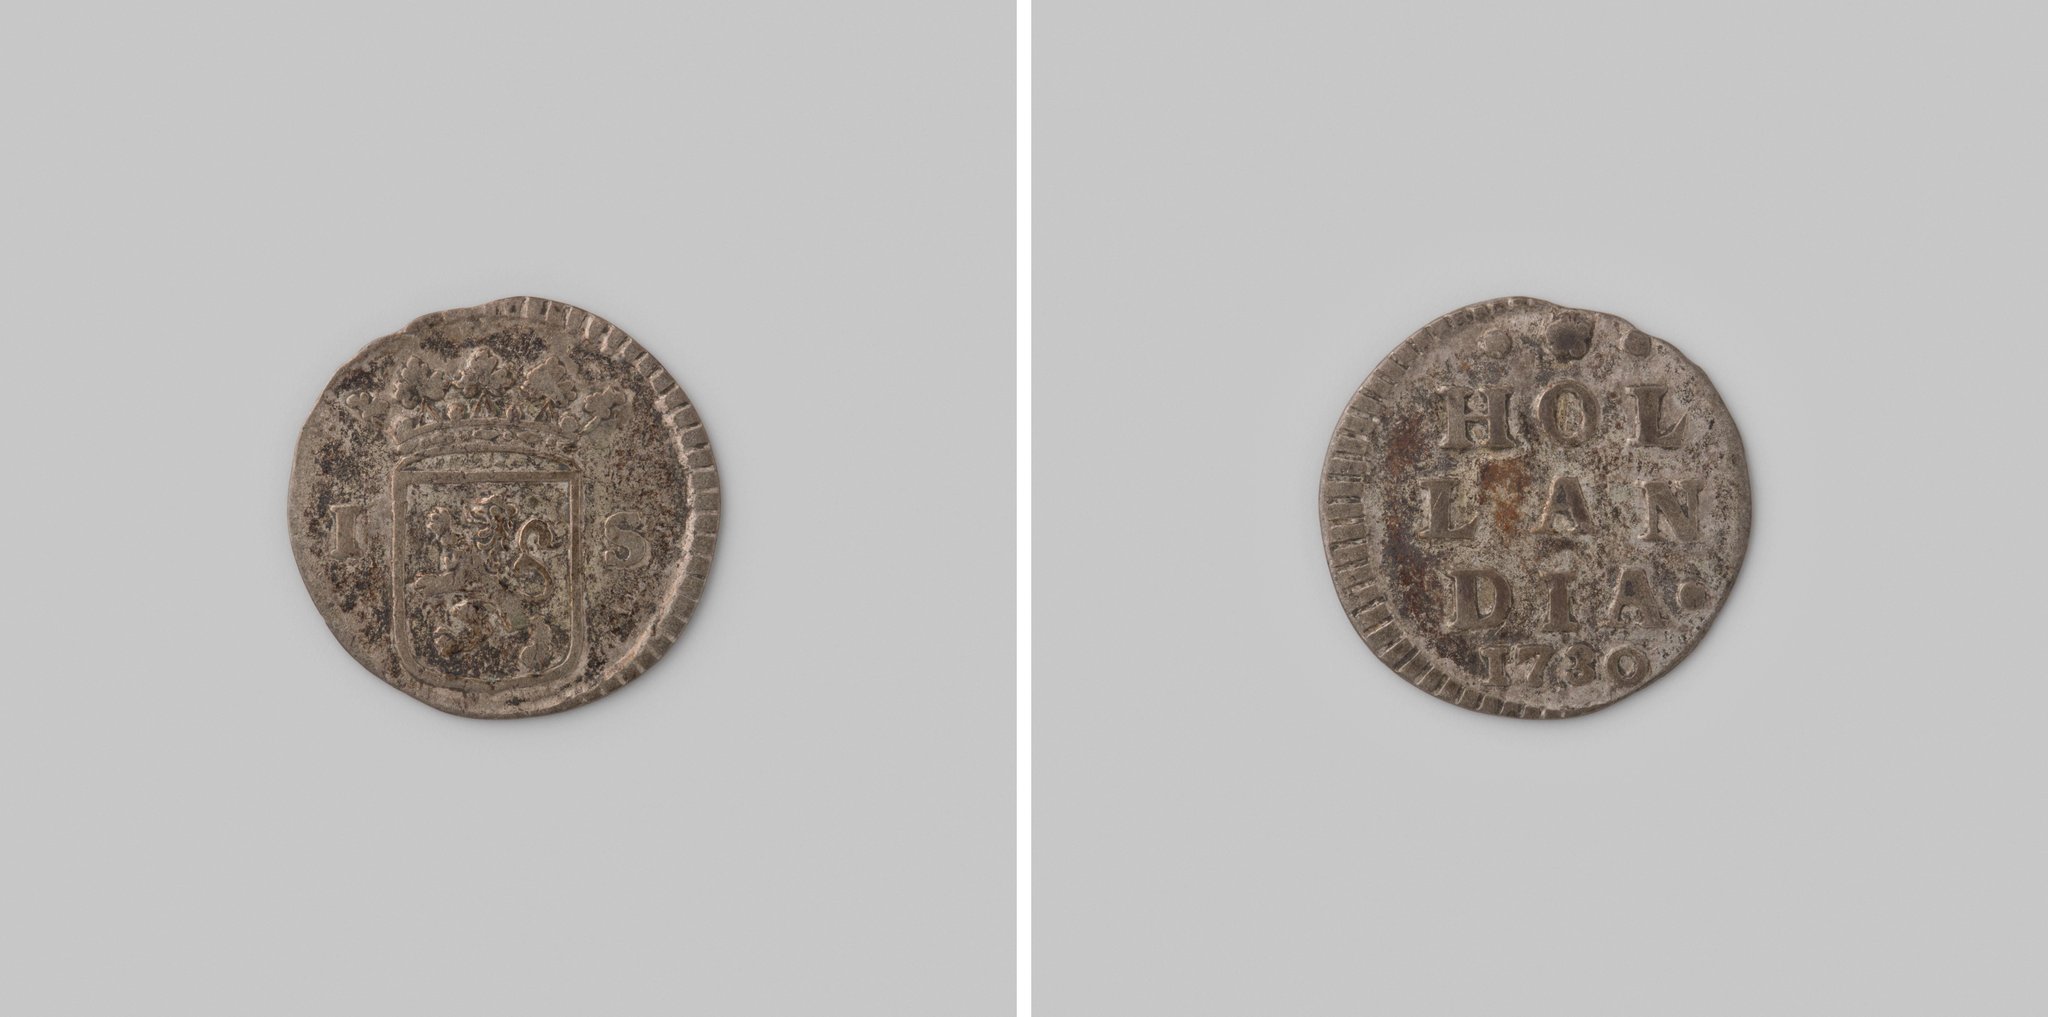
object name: coin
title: Holland, wapenstuiver, 1730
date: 1730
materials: silver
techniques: striking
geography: dordrecht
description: Zilveren munt. Voorzijde: tussen waarde-aanduiding gekroond wapenschild van Holland. Keerzijde: opschrift: provincienaam in drie regels, daaronder jaartal.